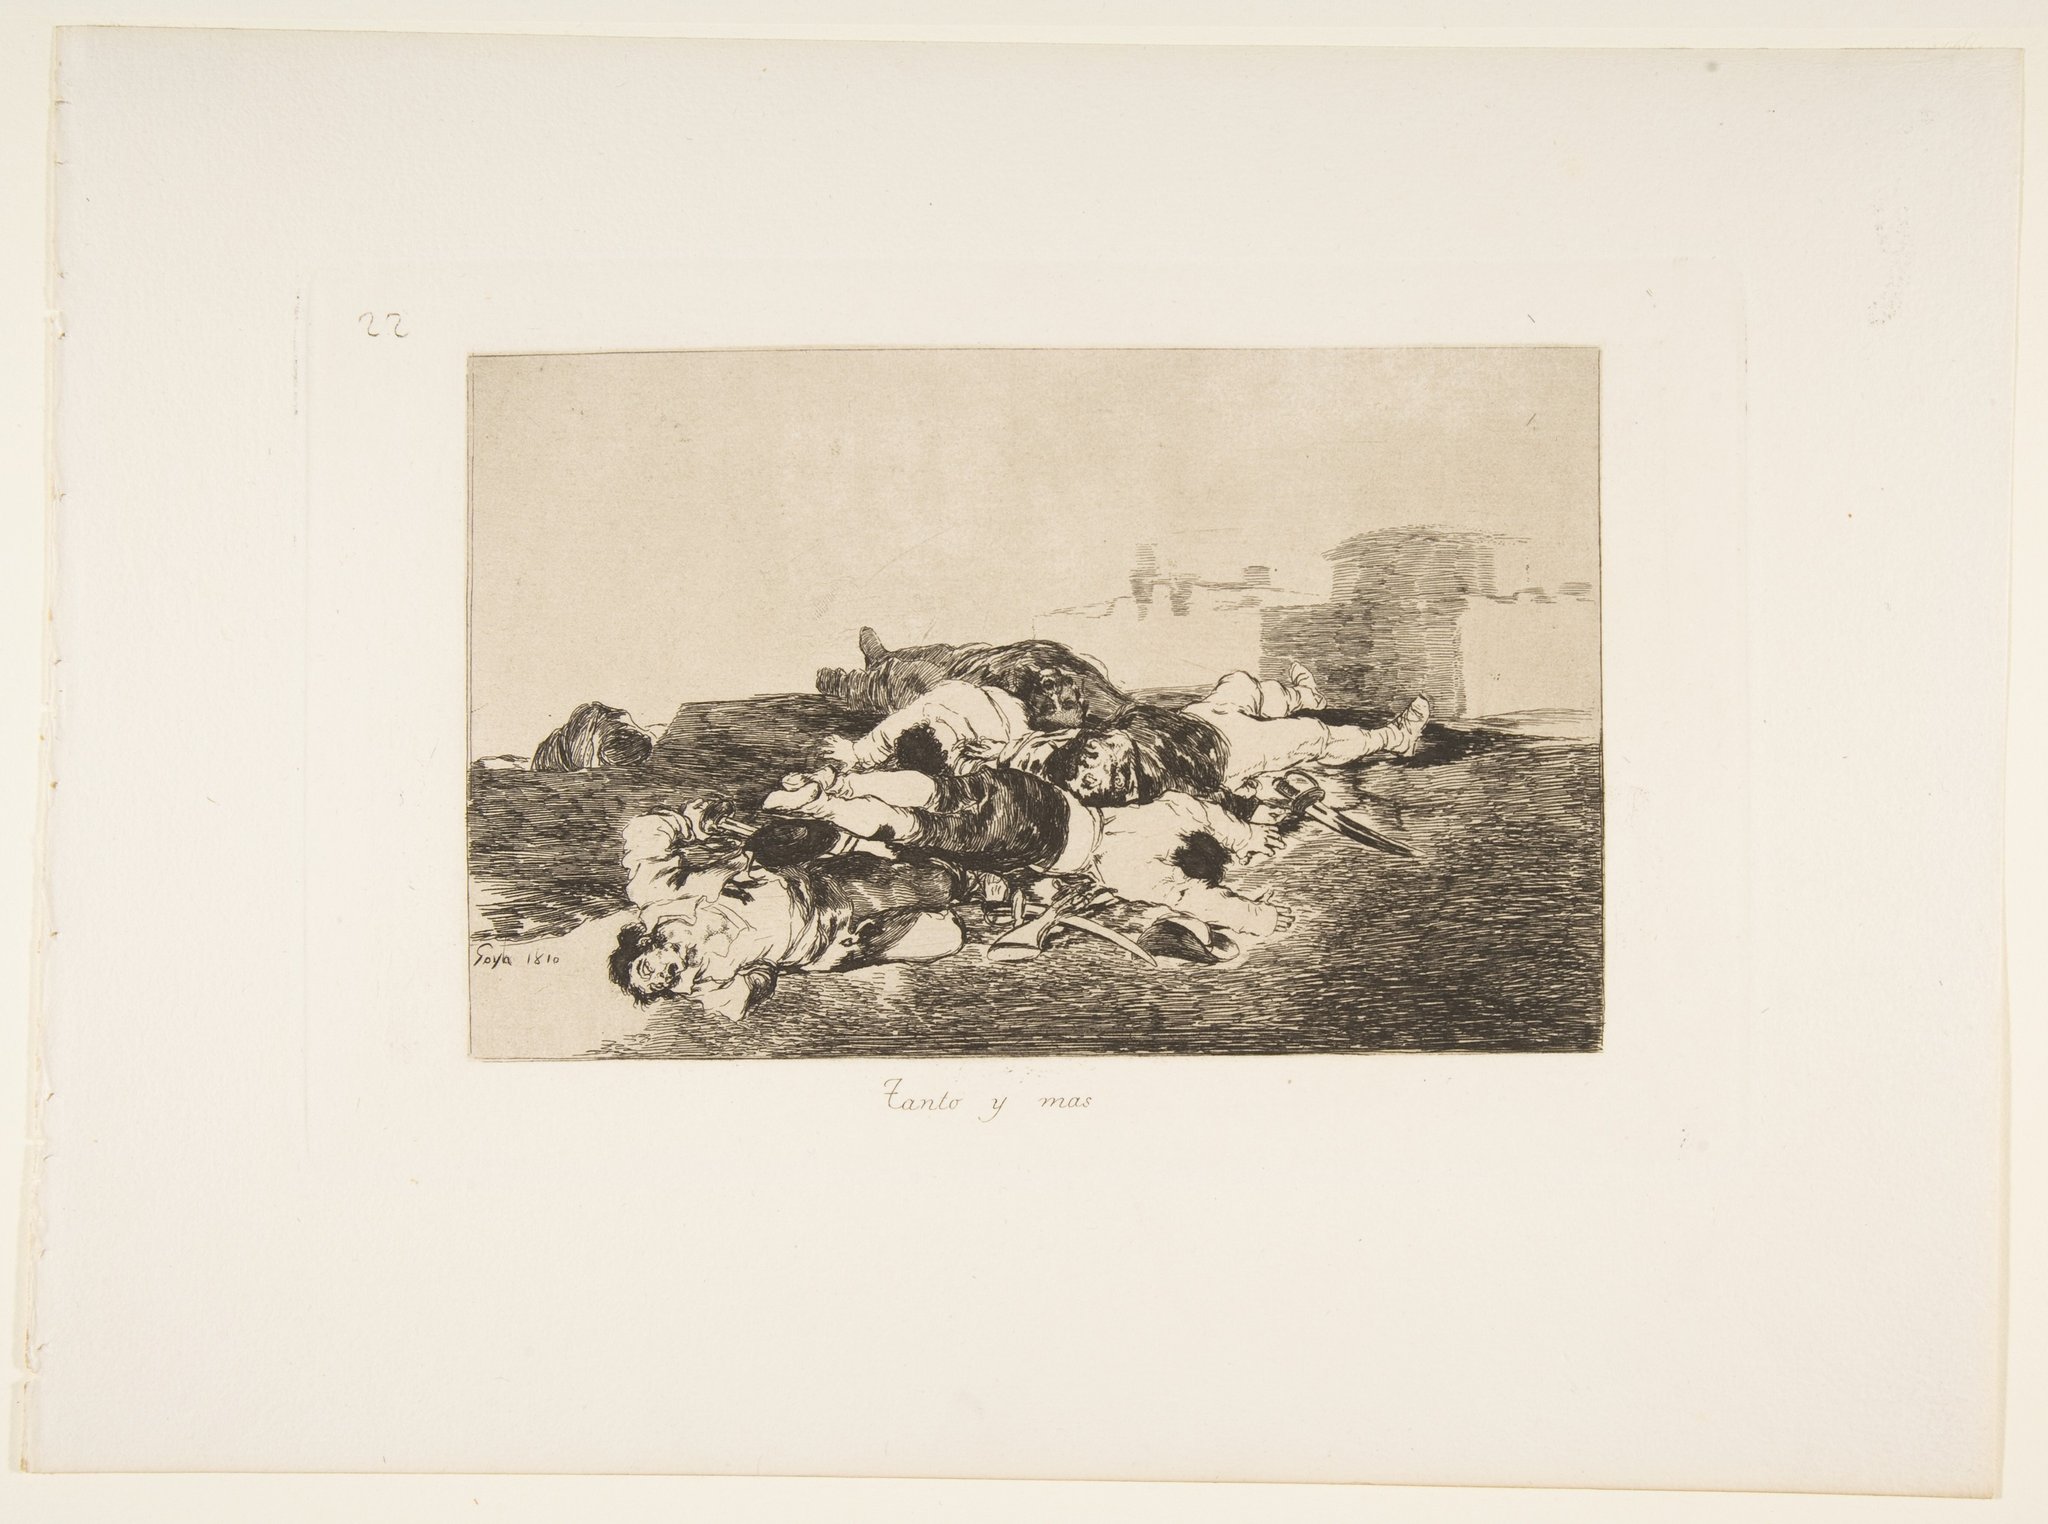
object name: print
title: Plate 22 from "The Disasters of War" (Los Desastres de la Guerra): 'Even worse' (Tanto y mas)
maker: goya (francisco de goya y lucientes)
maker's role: artist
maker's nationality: spanish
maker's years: 1746-1828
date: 1810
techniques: engraving, etching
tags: corpses